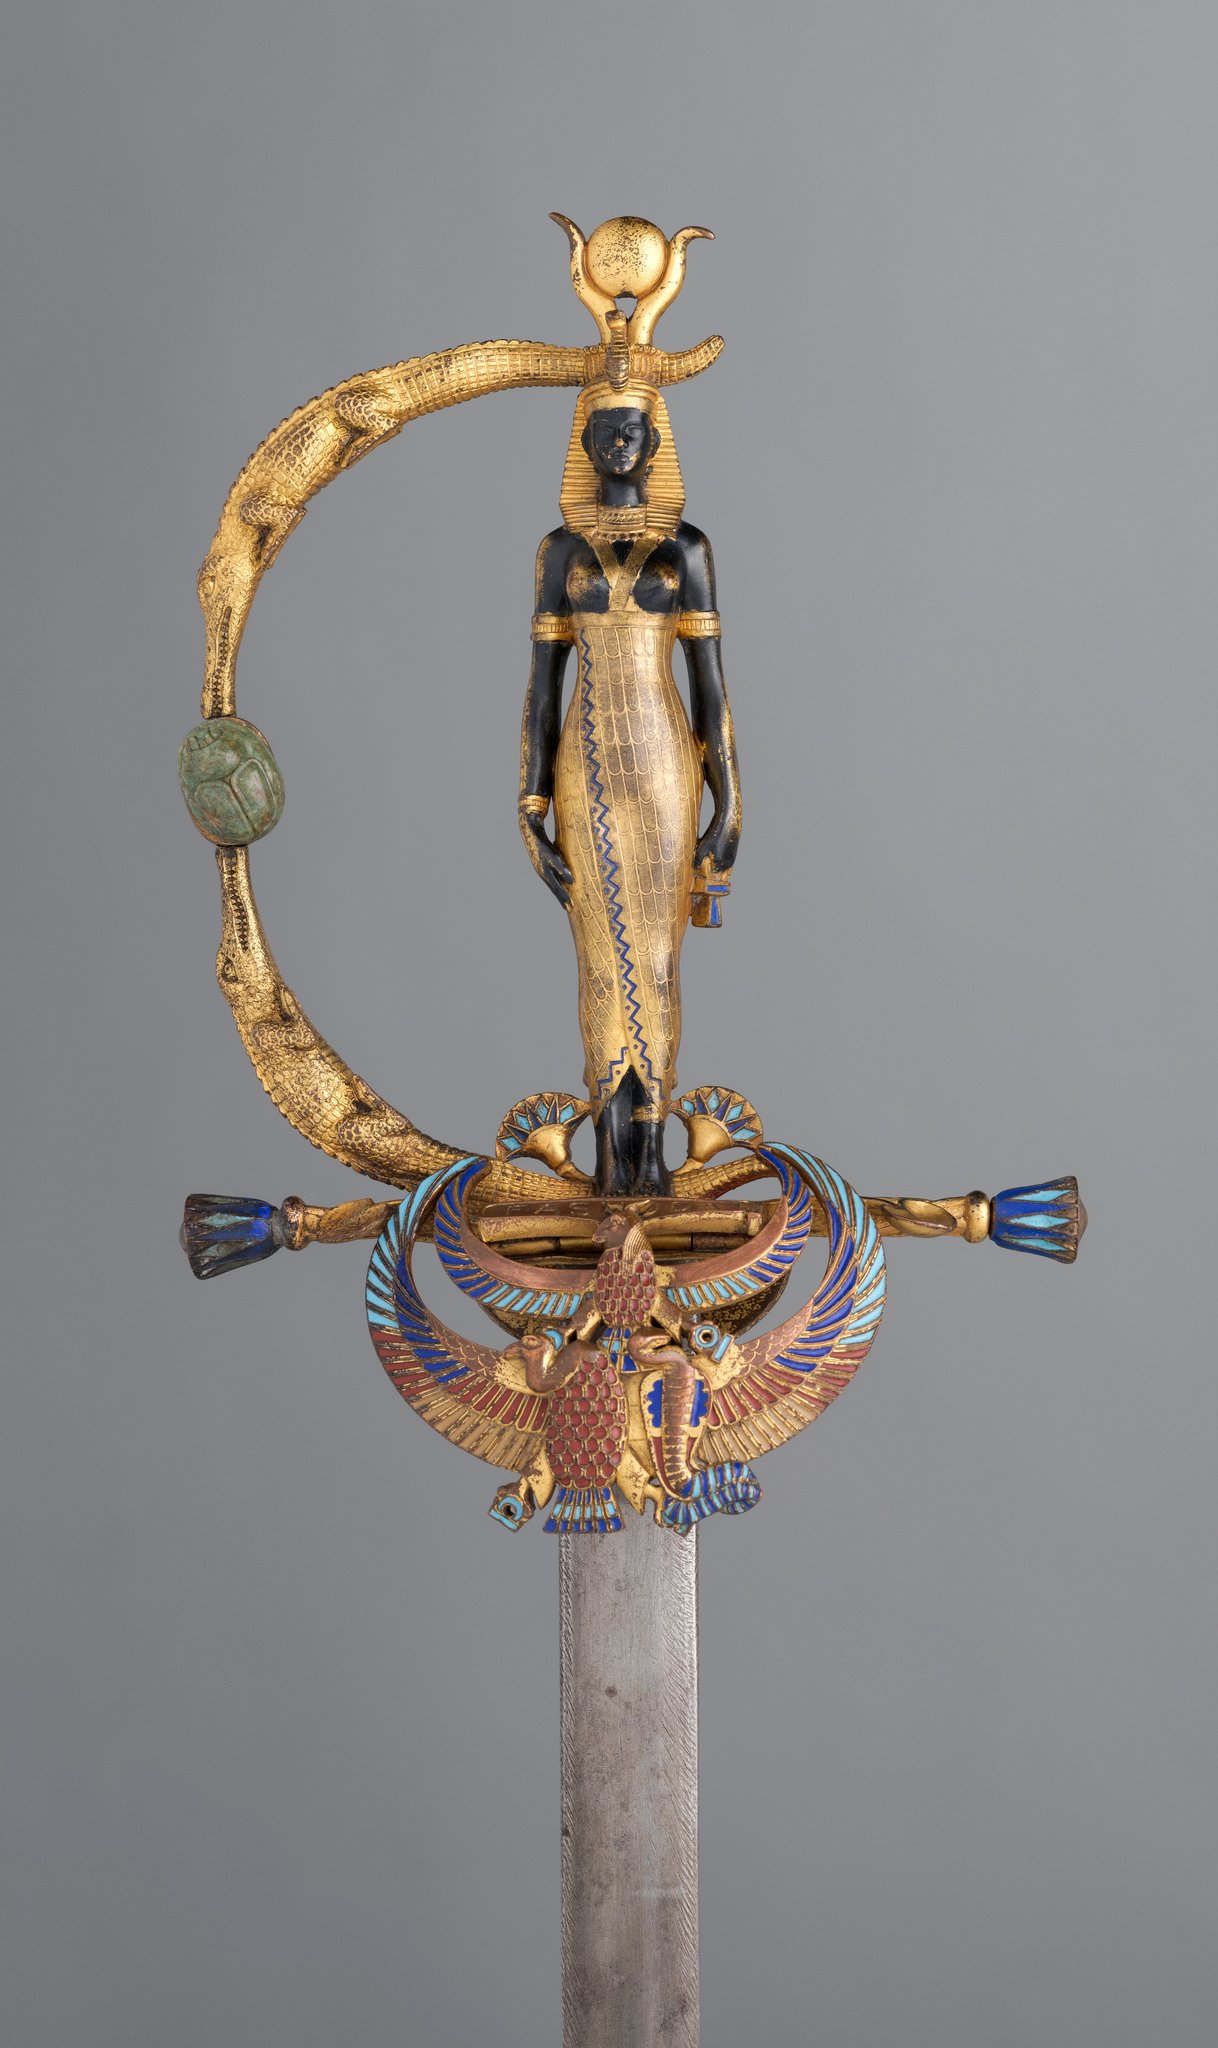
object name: presentation sword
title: Presentation Sword Honoring Commandant Jean-Baptiste Marchand (1863–1934) for His Conduct at Fashoda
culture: french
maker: jean-joseph-marie-anatole marquet de vasselot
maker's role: designer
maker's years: 1840-1904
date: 1889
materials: copper alloy, enamel, gold, jade, steel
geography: france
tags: crocodiles